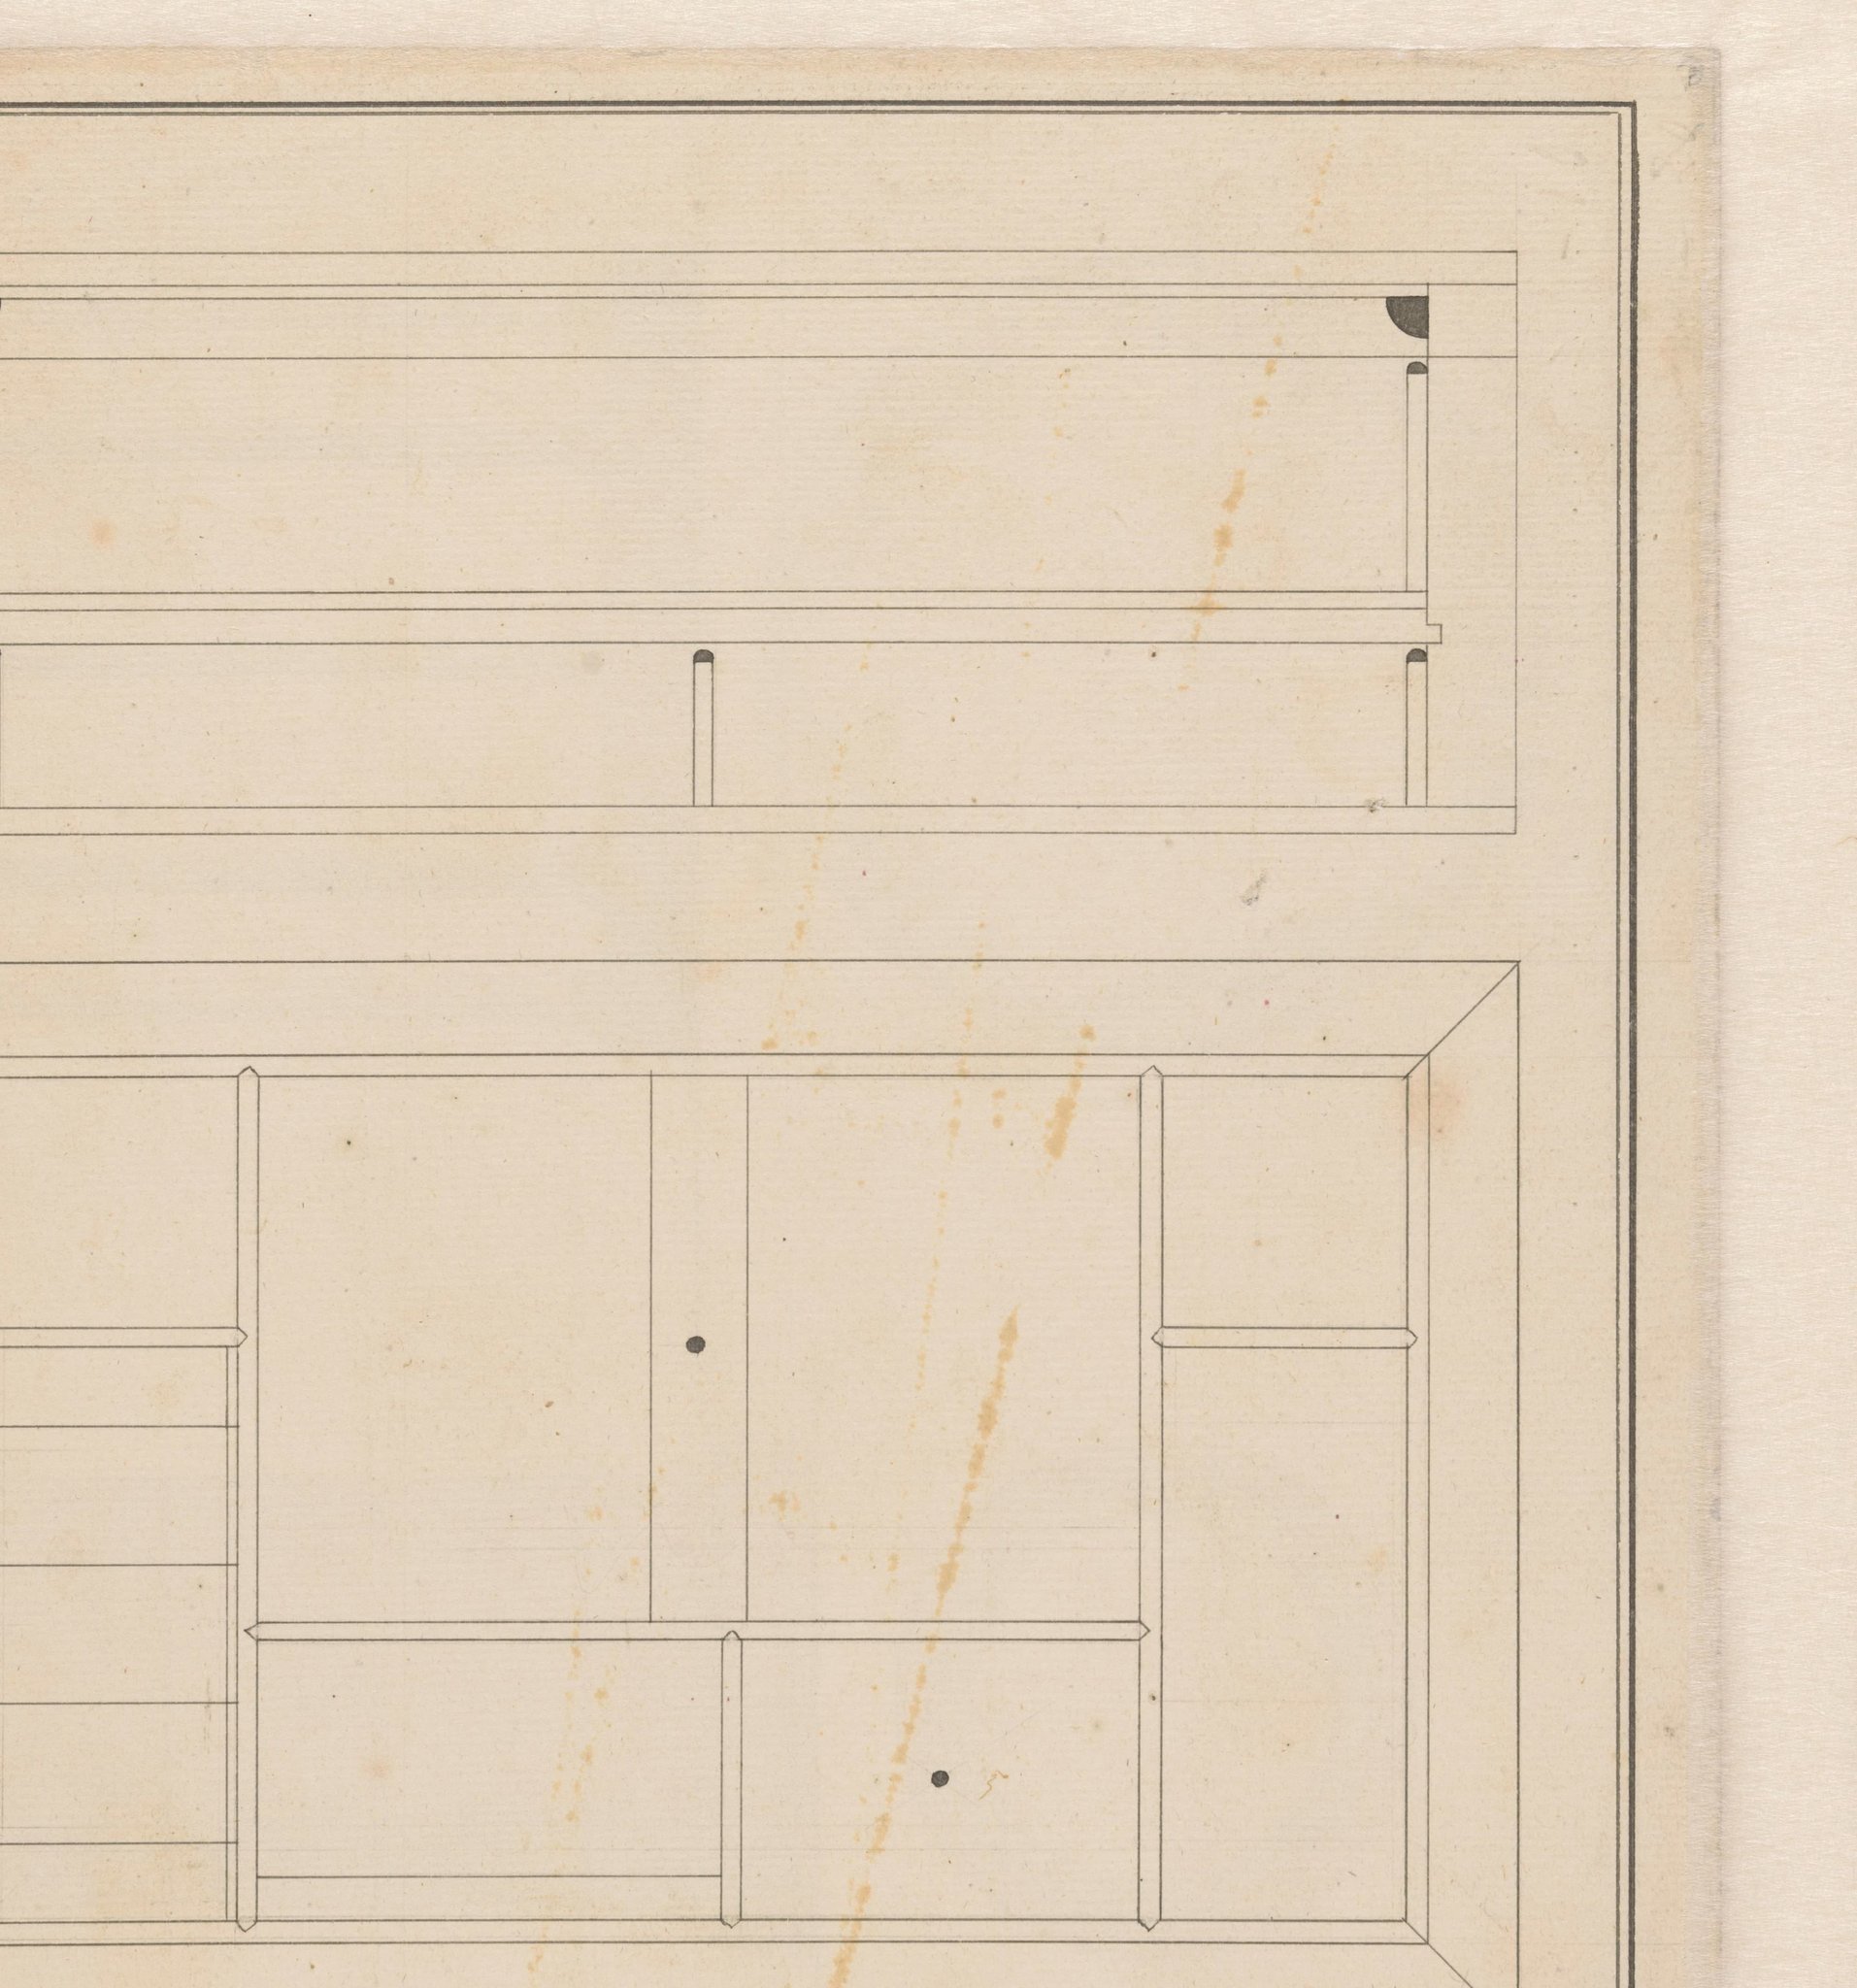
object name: design drawing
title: Twee ontwerpen voor de verdeling van het interieur van een schrijf- of documentendoos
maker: joseph nussbaumer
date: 1816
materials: ink, paper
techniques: pen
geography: vienna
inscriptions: signature and date: ‘Joseph Nussbaumer gezeichnet / in Wien 1816’